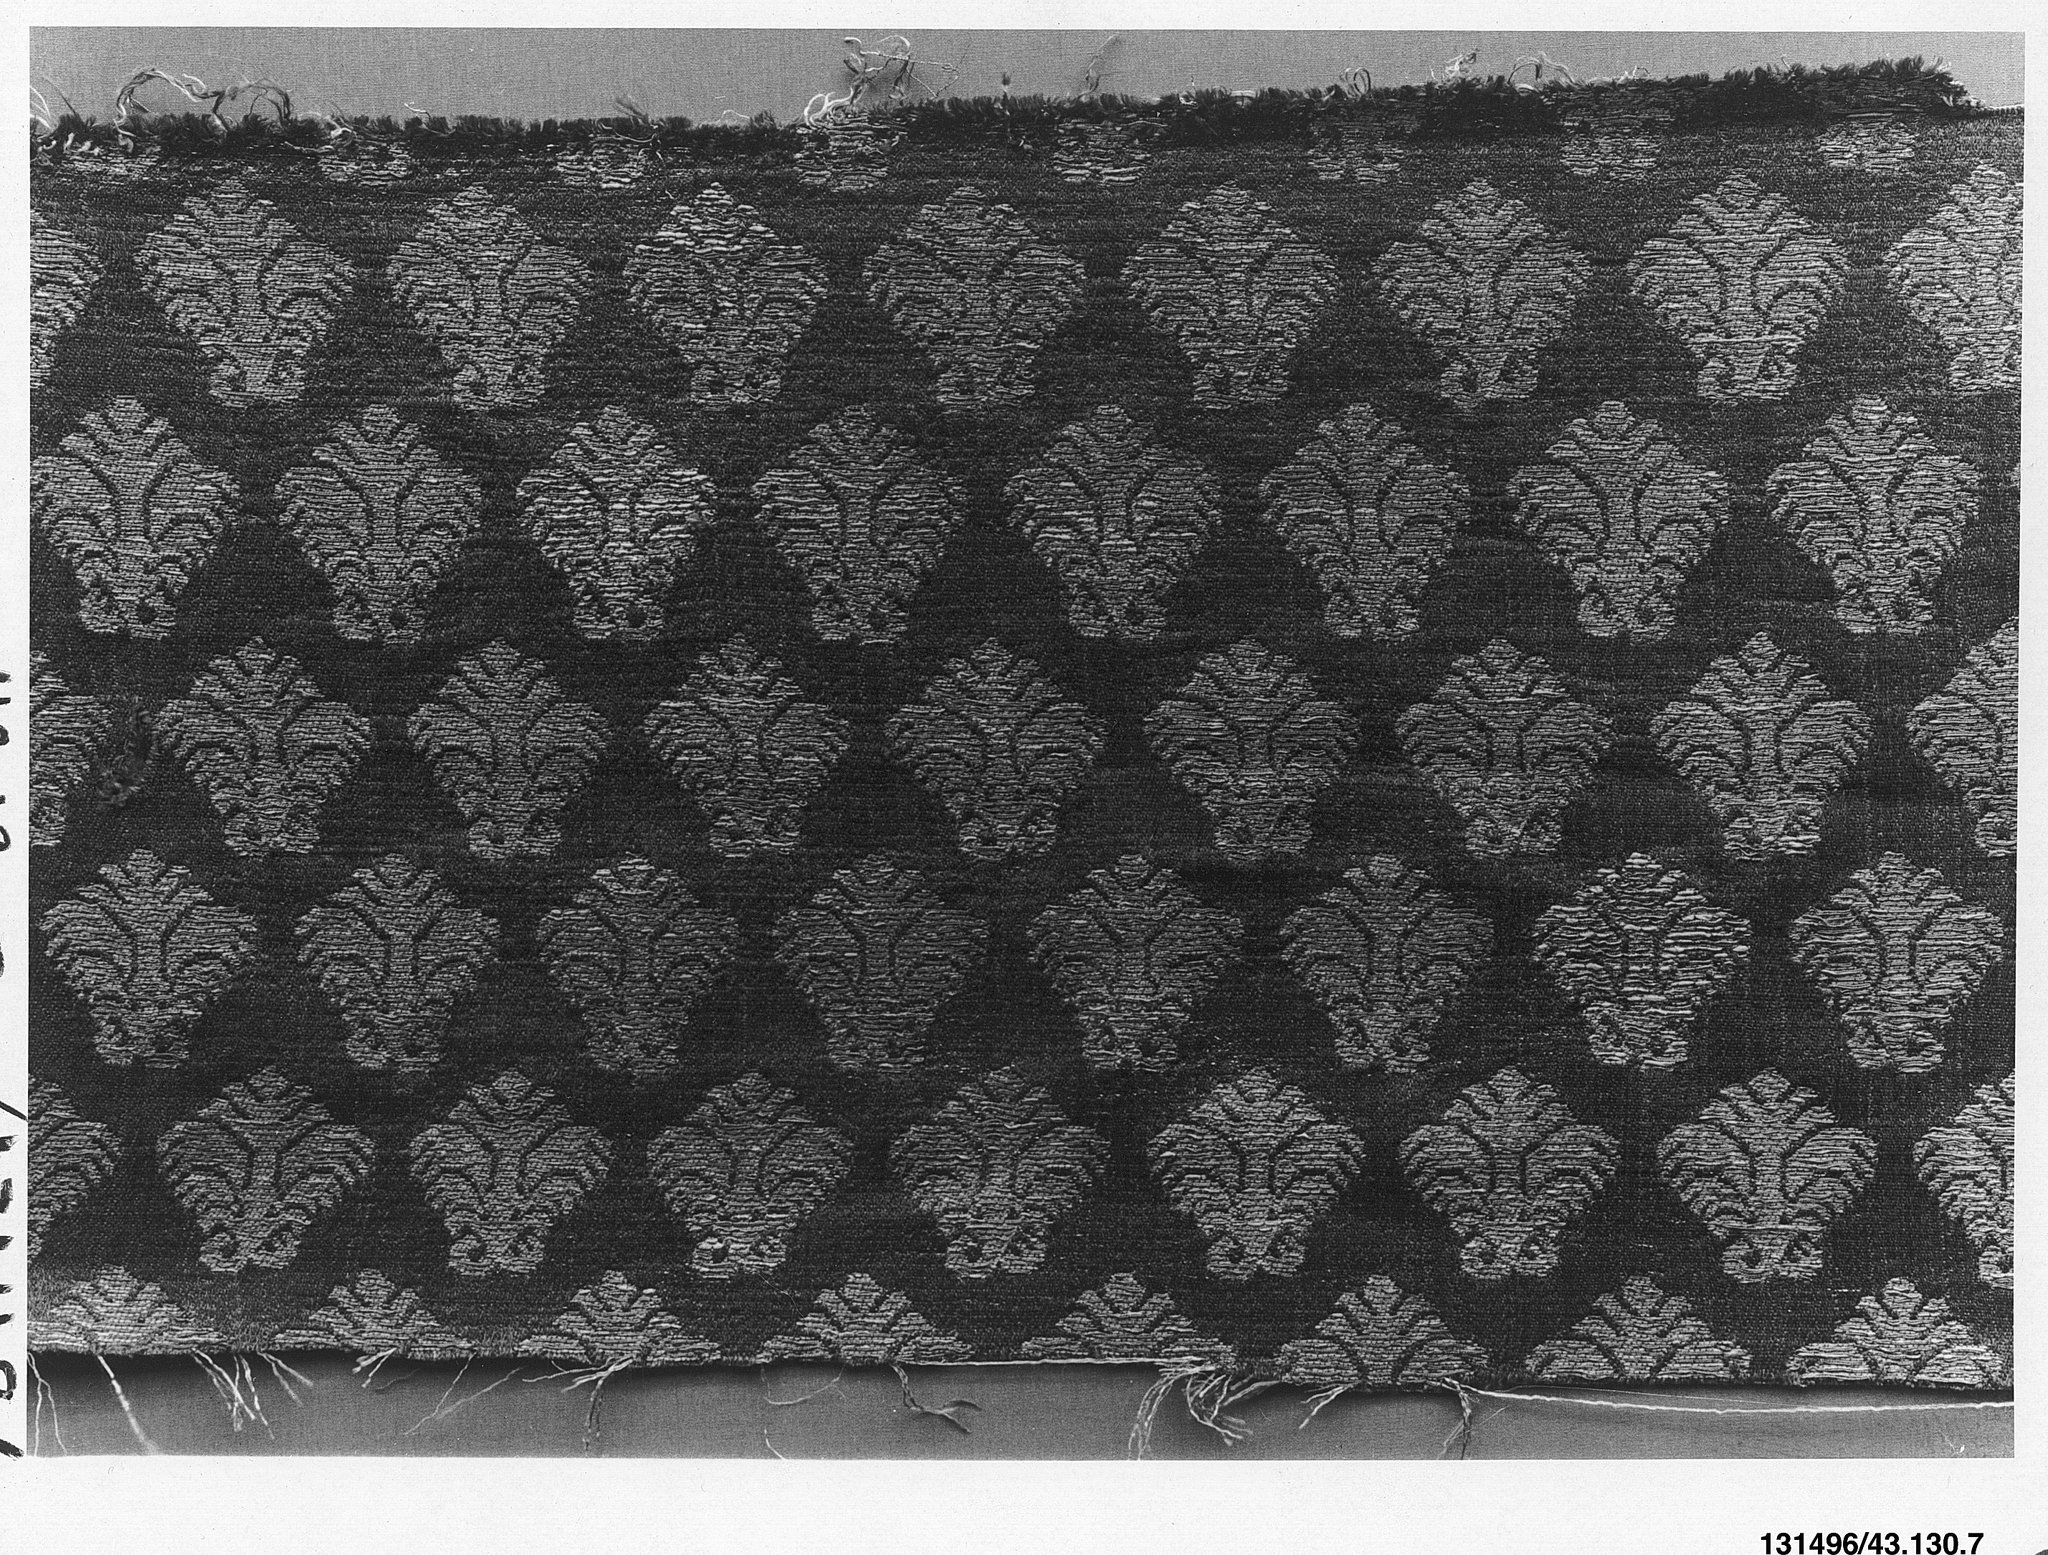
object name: piece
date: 1767-1800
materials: metal thread, silk